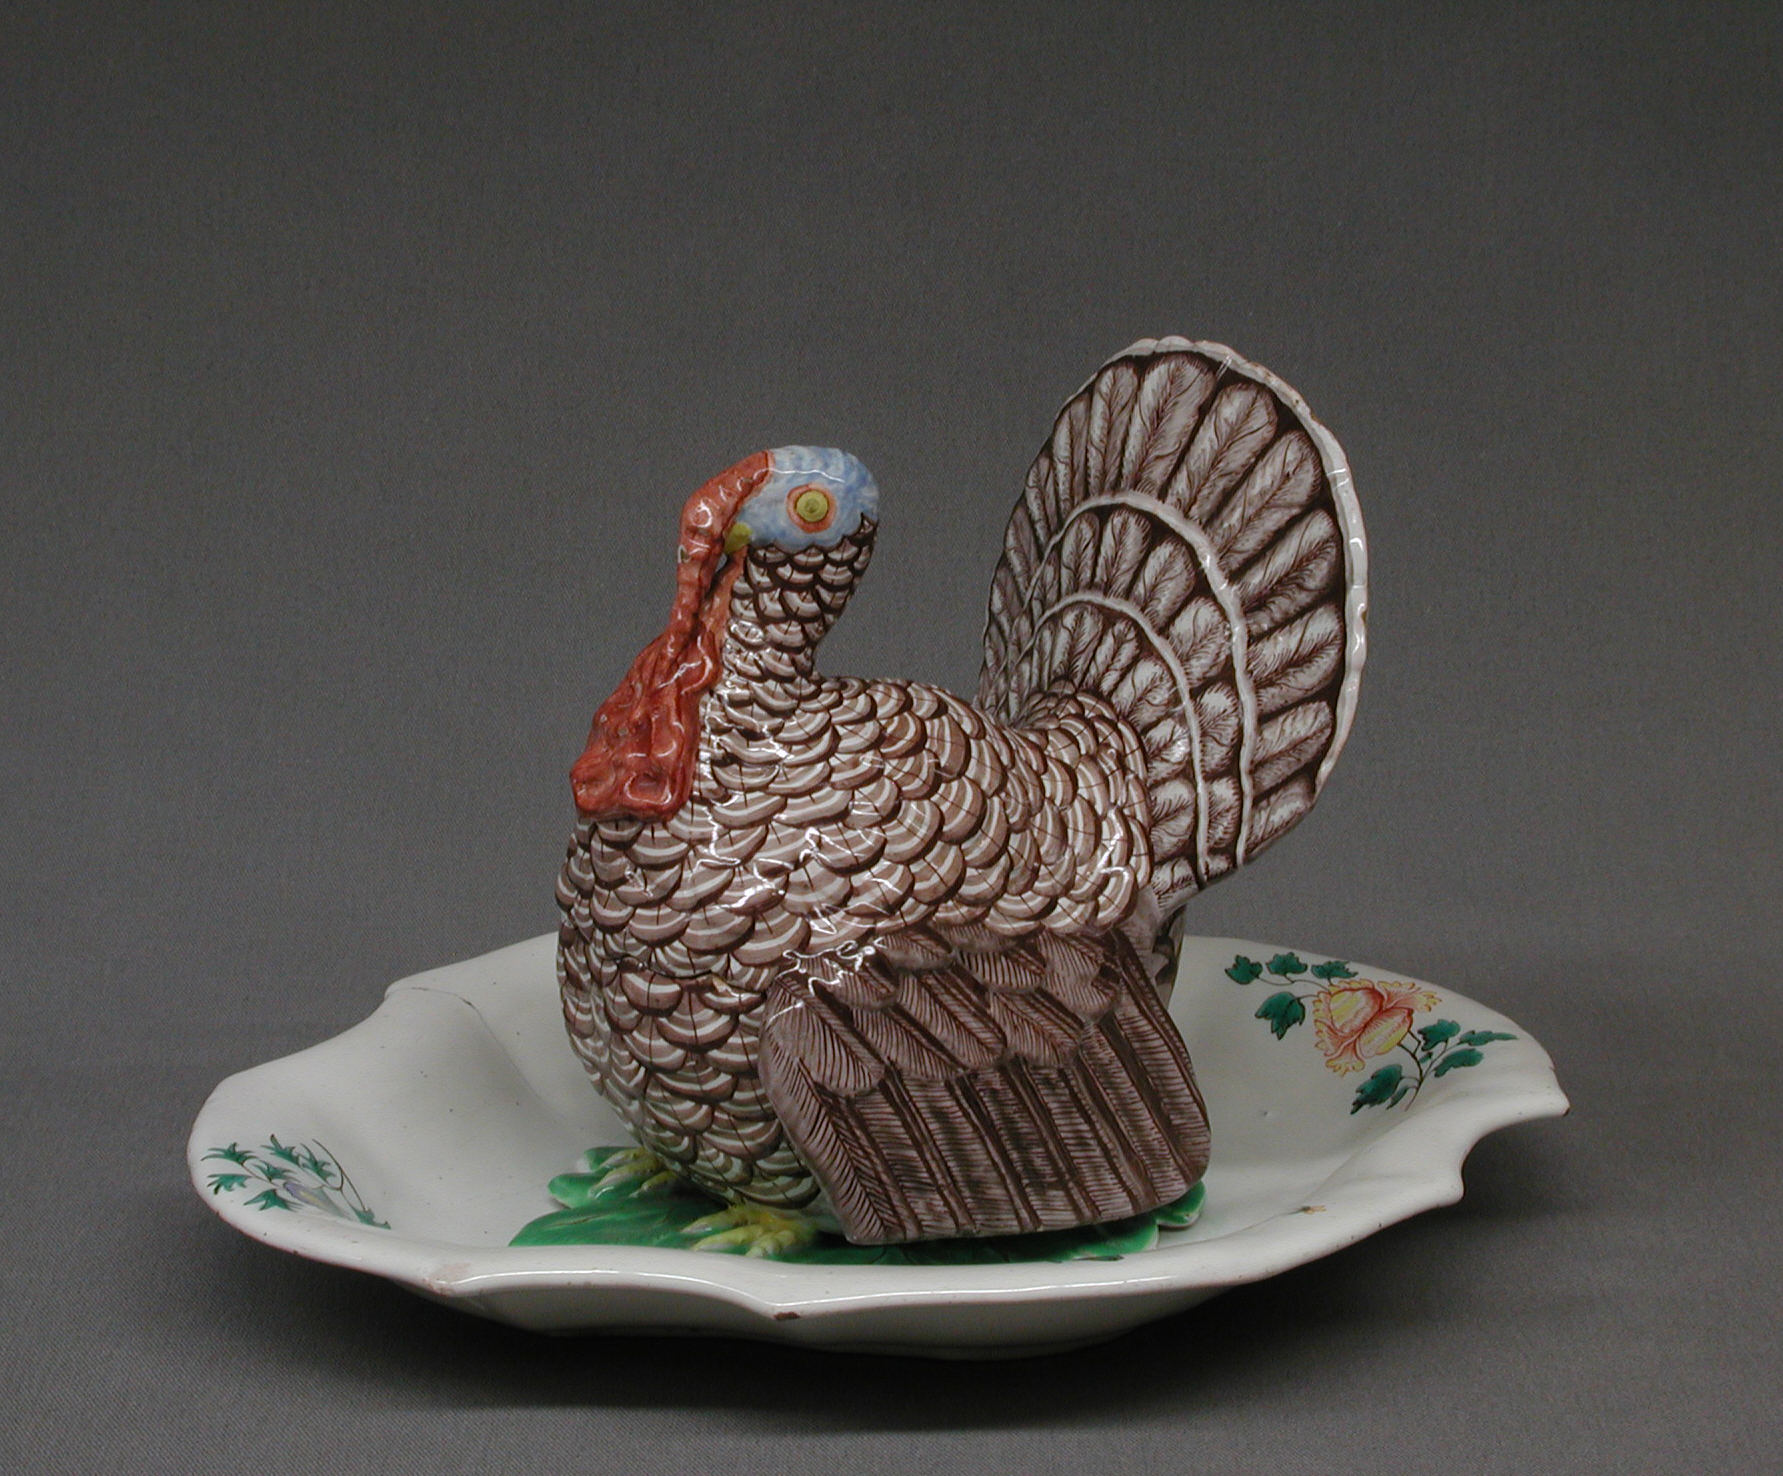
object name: tureen with cover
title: Tureen with cover in the form of a turkey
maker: florsheim manufactory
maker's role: manufactory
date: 1750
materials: earthenware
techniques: glazing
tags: turkeys